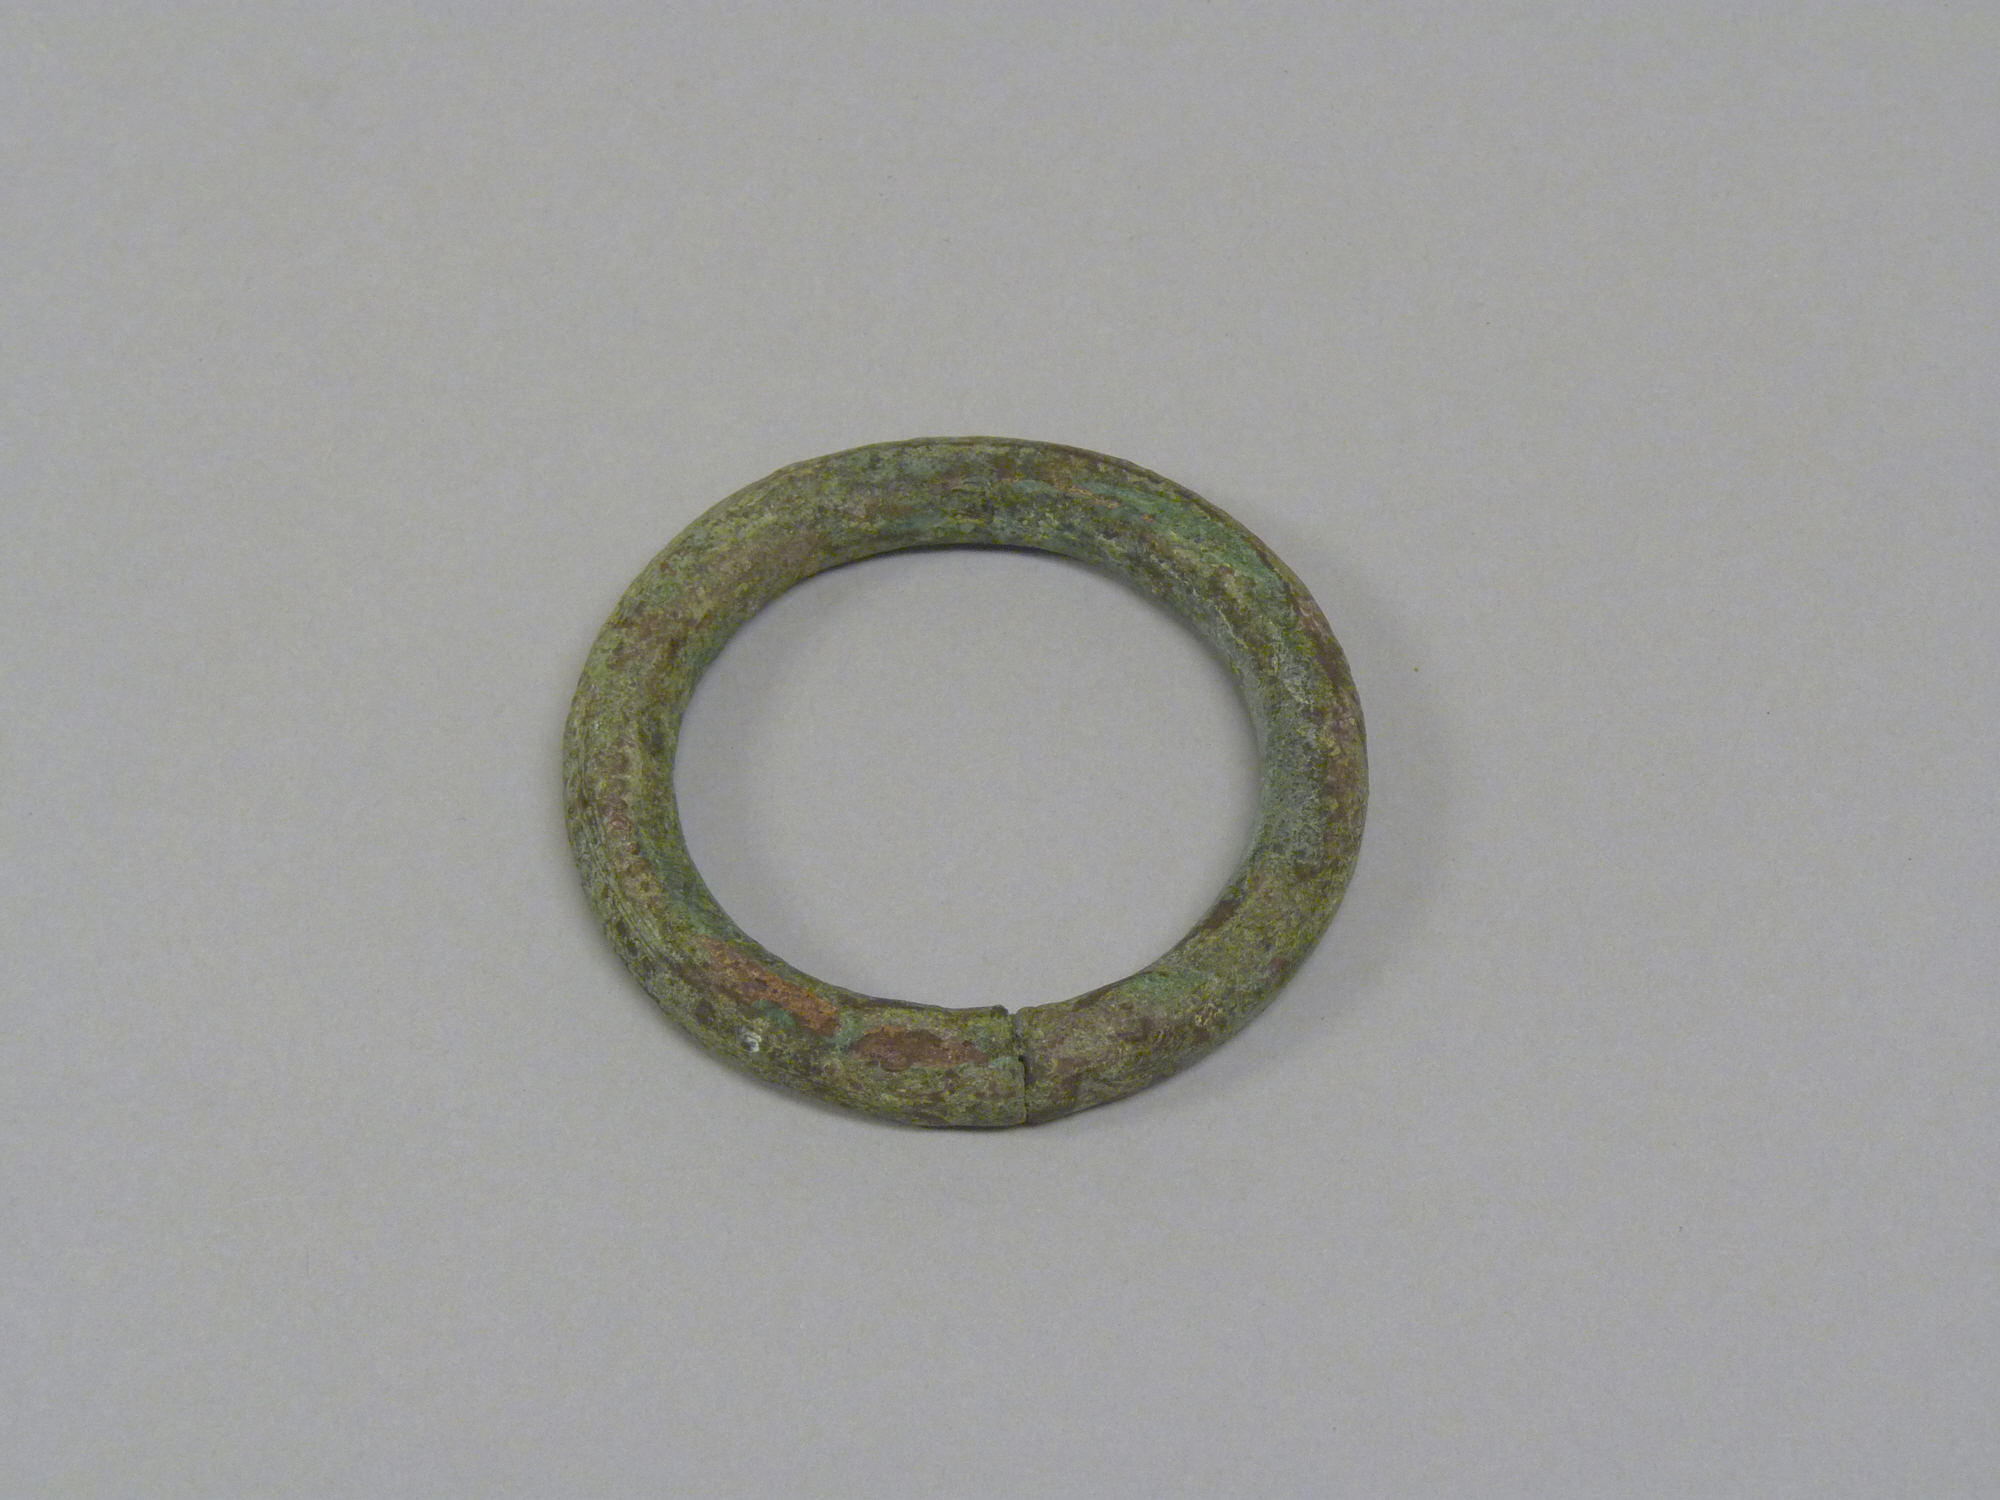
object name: bracelet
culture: thai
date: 500 BCE-300 CE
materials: bronze